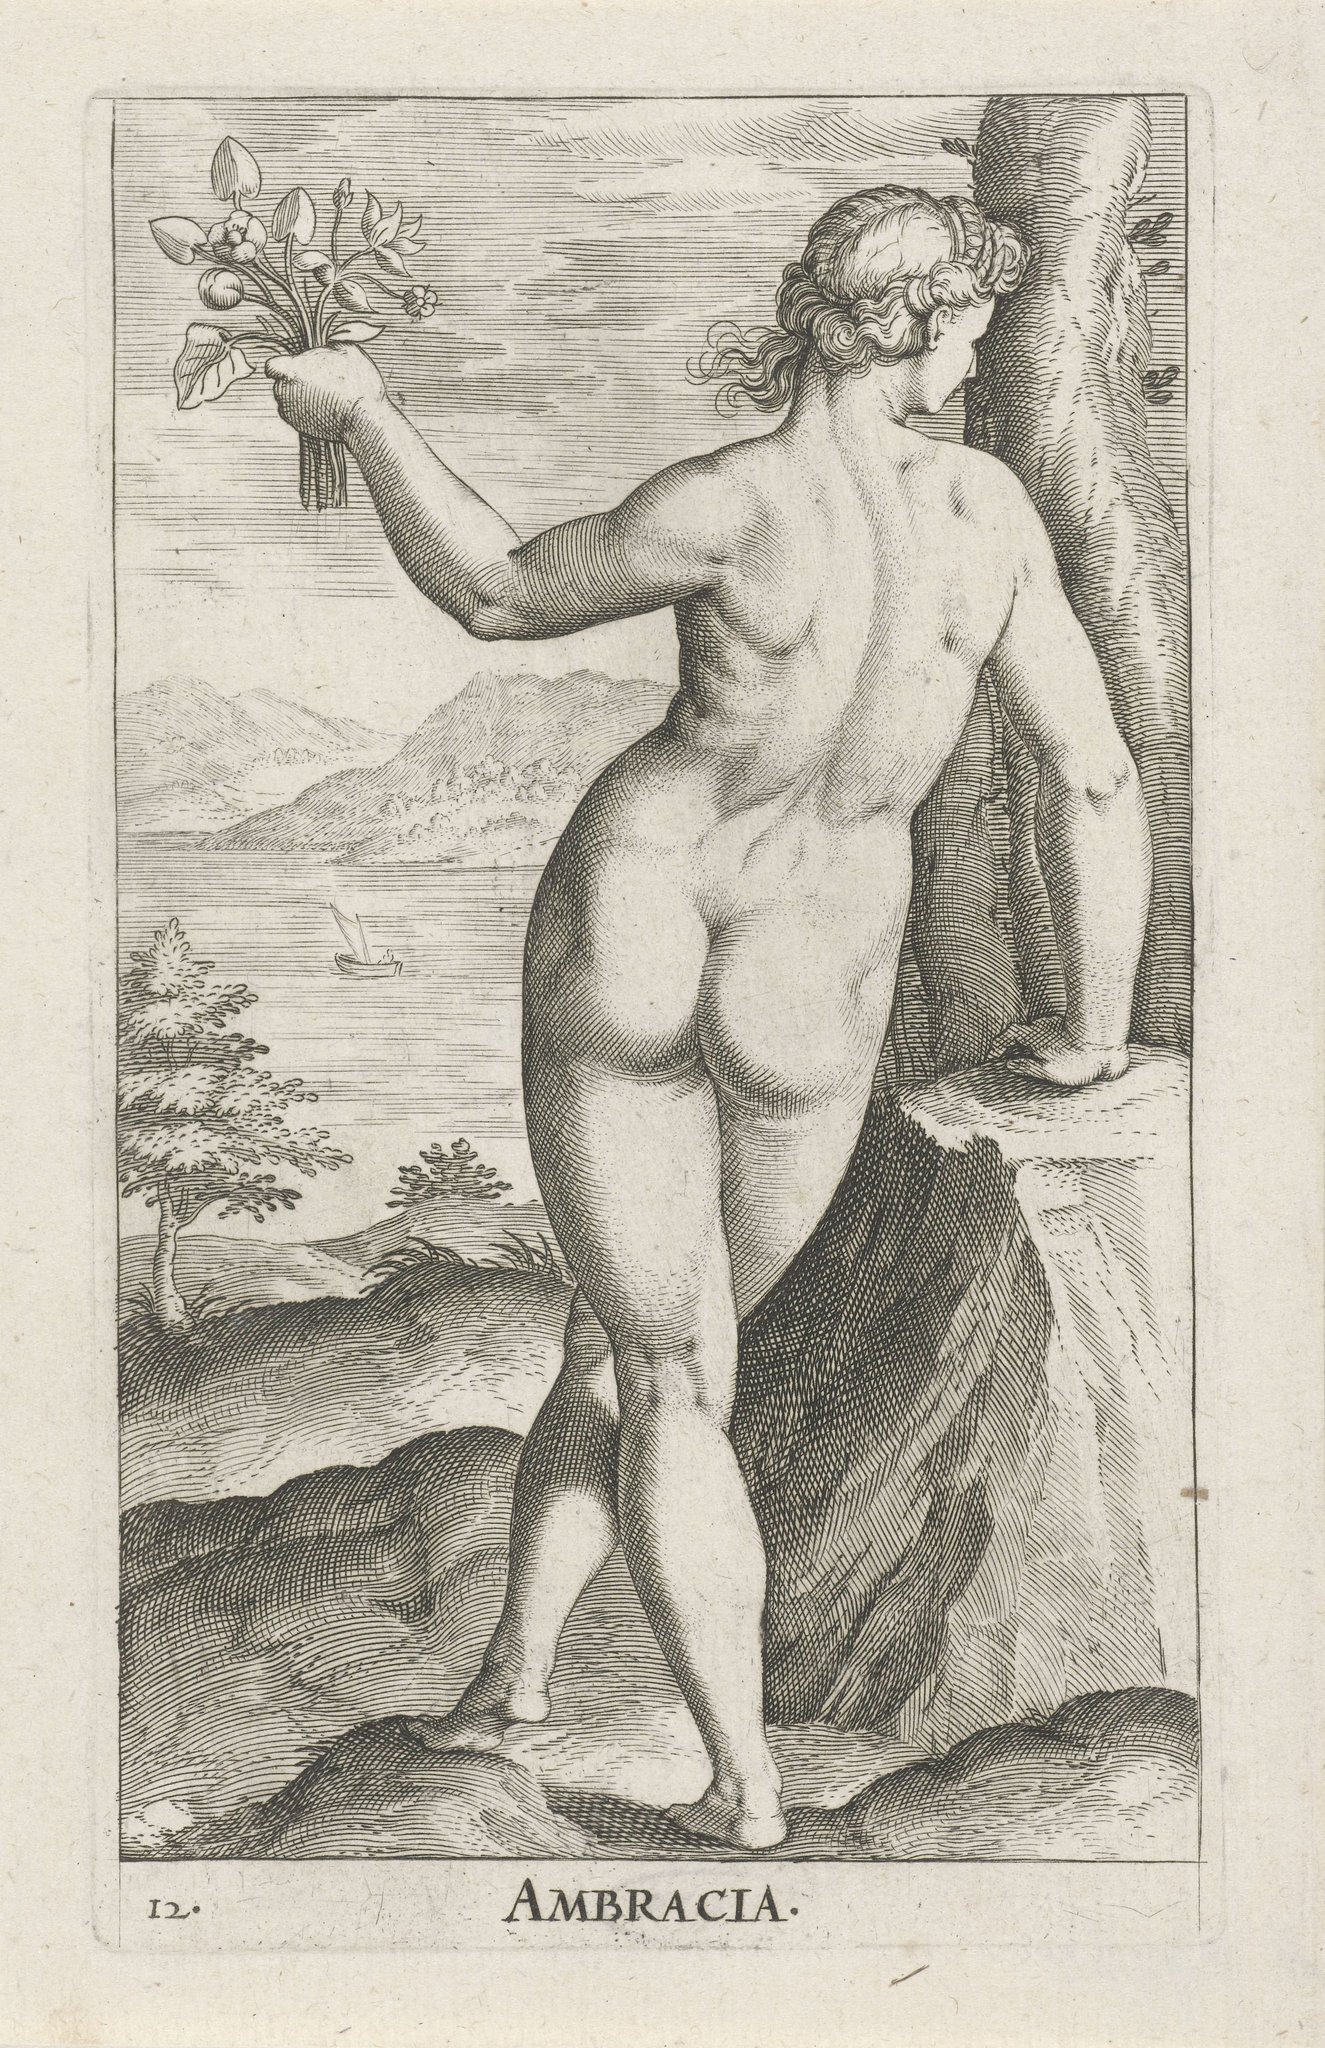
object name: print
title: Stroom- en waternimfen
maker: philips galle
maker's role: print maker, publisher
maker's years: 1537-1612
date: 1587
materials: paper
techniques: engraving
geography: antwerp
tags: other nereids (or sea-nymphs) (with name)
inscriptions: collector's mark: Lugt 2228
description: De waternimf Ambracia (de golf van Arta). In haar hand een tuil bloemen. De prent maakt deel uit van een zeventiendelige serie over stroom- en waternimfen.